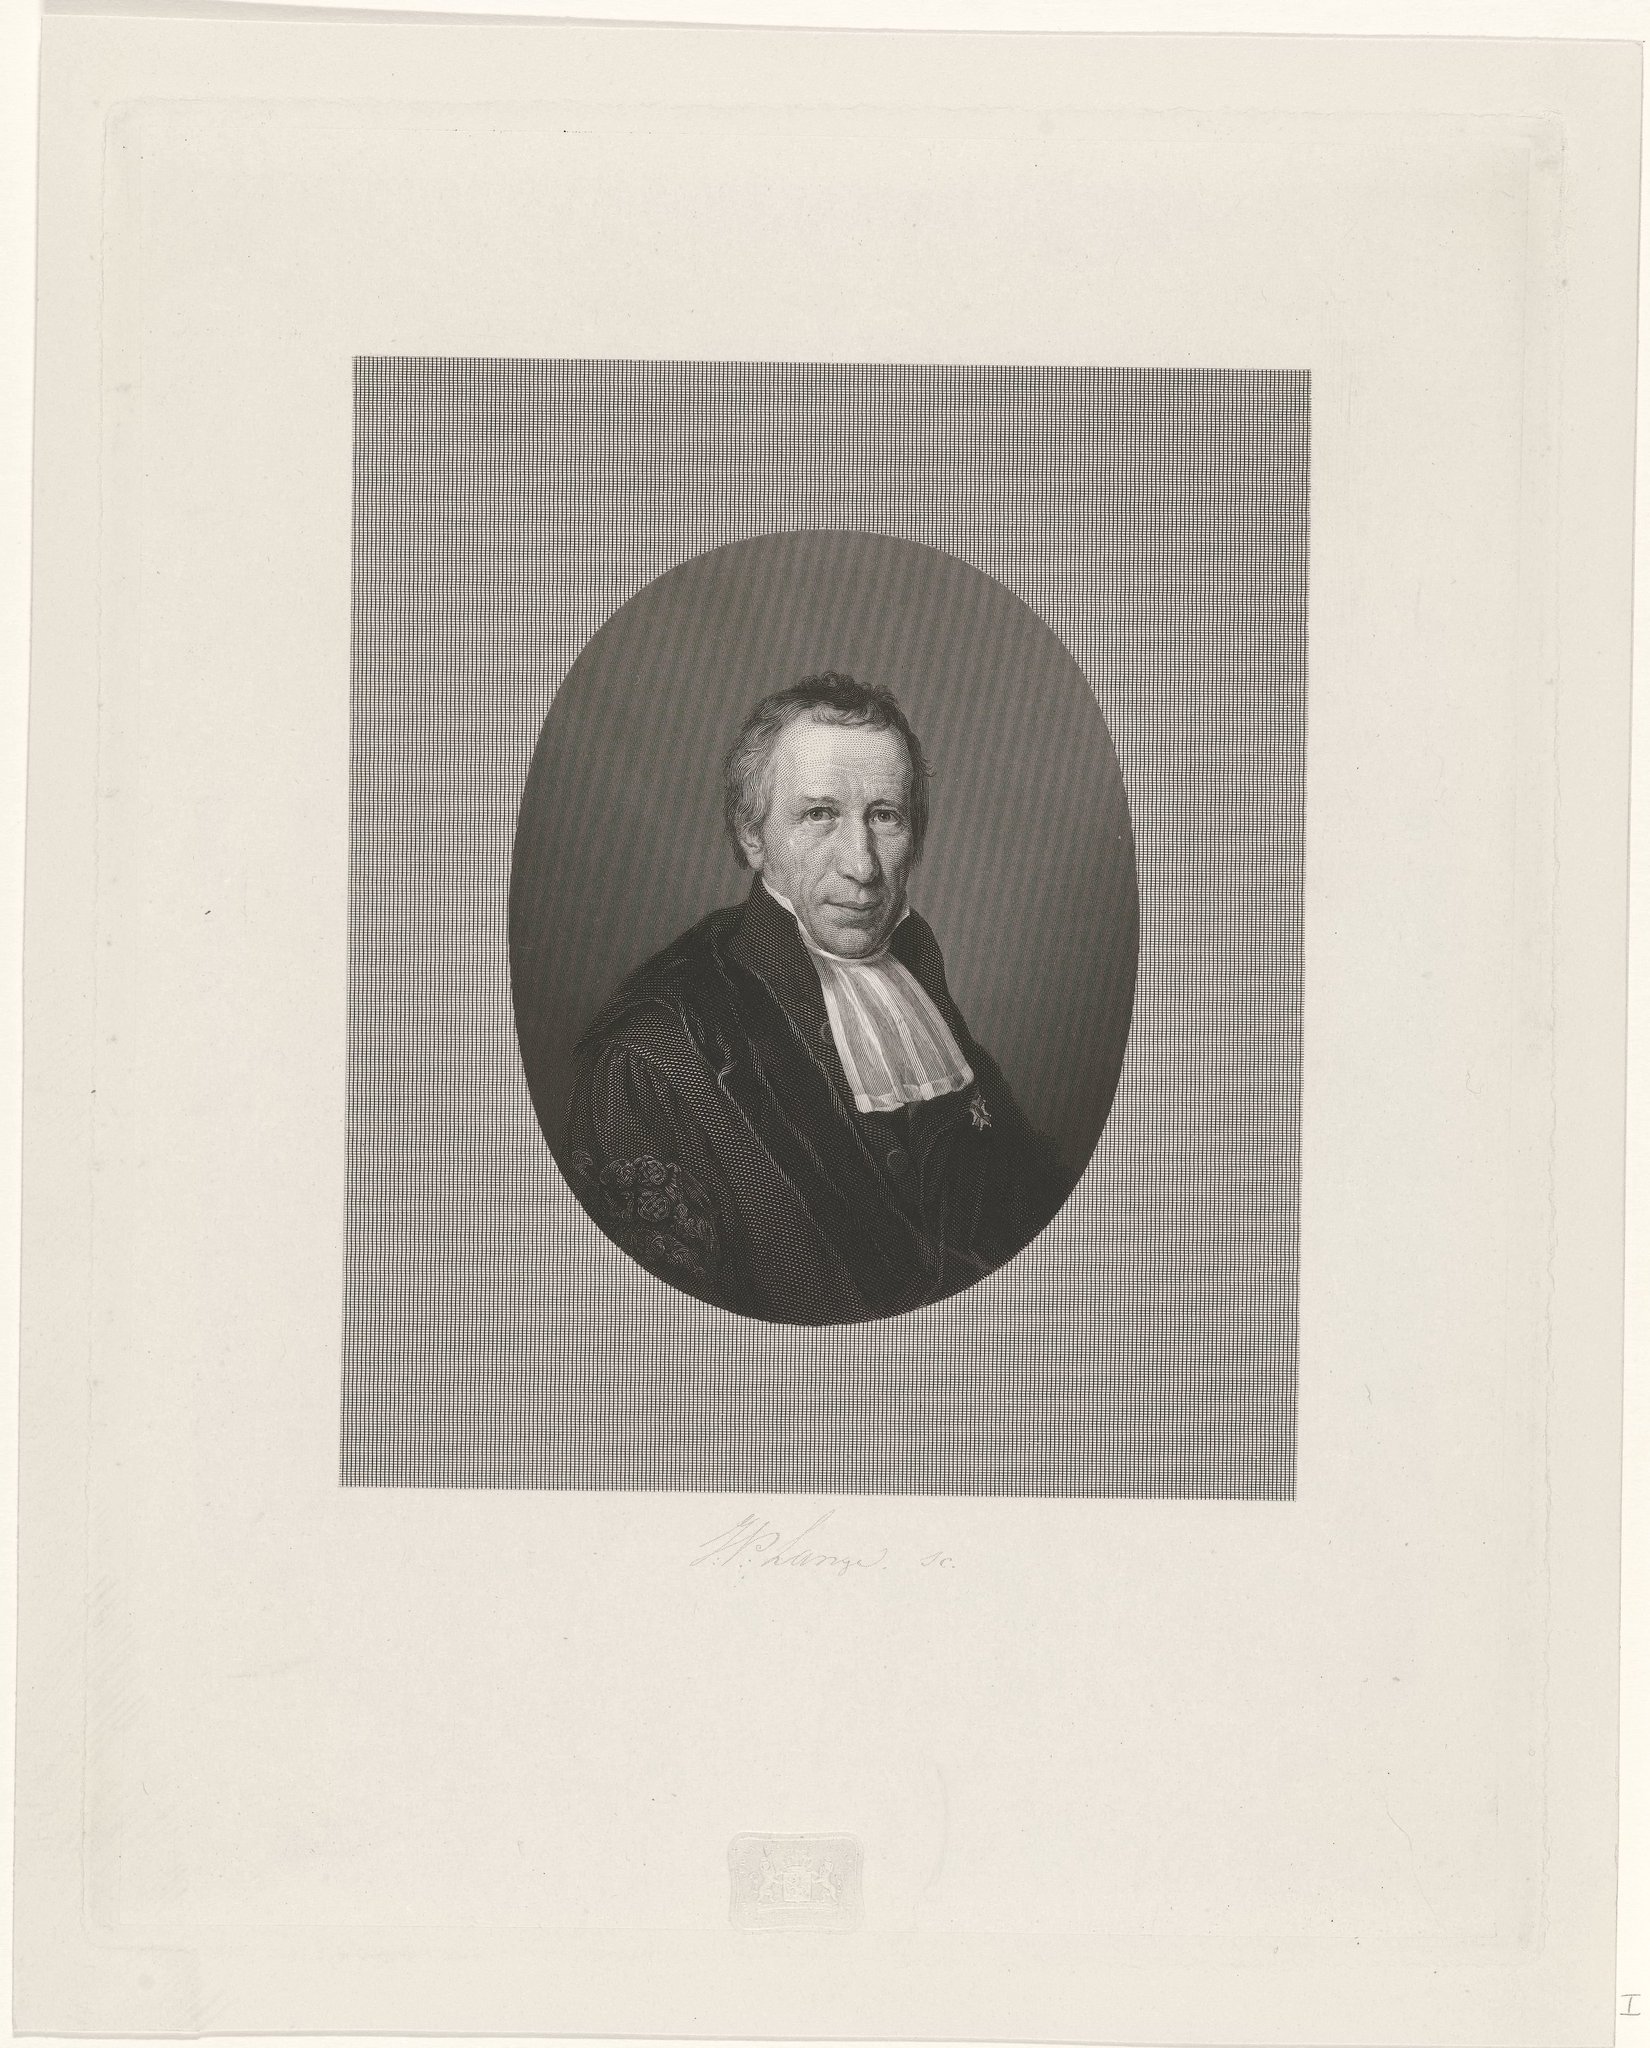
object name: print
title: Portret van Johannes Frederik Lodewijk Schröder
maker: johannes philippus lange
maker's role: print maker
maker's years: 1810-1849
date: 1820-1849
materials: paper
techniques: engraving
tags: utrecht, physicist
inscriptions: check stamp, collector's mark: Lugt 2228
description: Portretbuste in ovaal naar rechts van Johannes Frederik Lodewijk Schröder, theoloog, wis- en natuurkundige, in toga met bef en ridderorde op de borst.